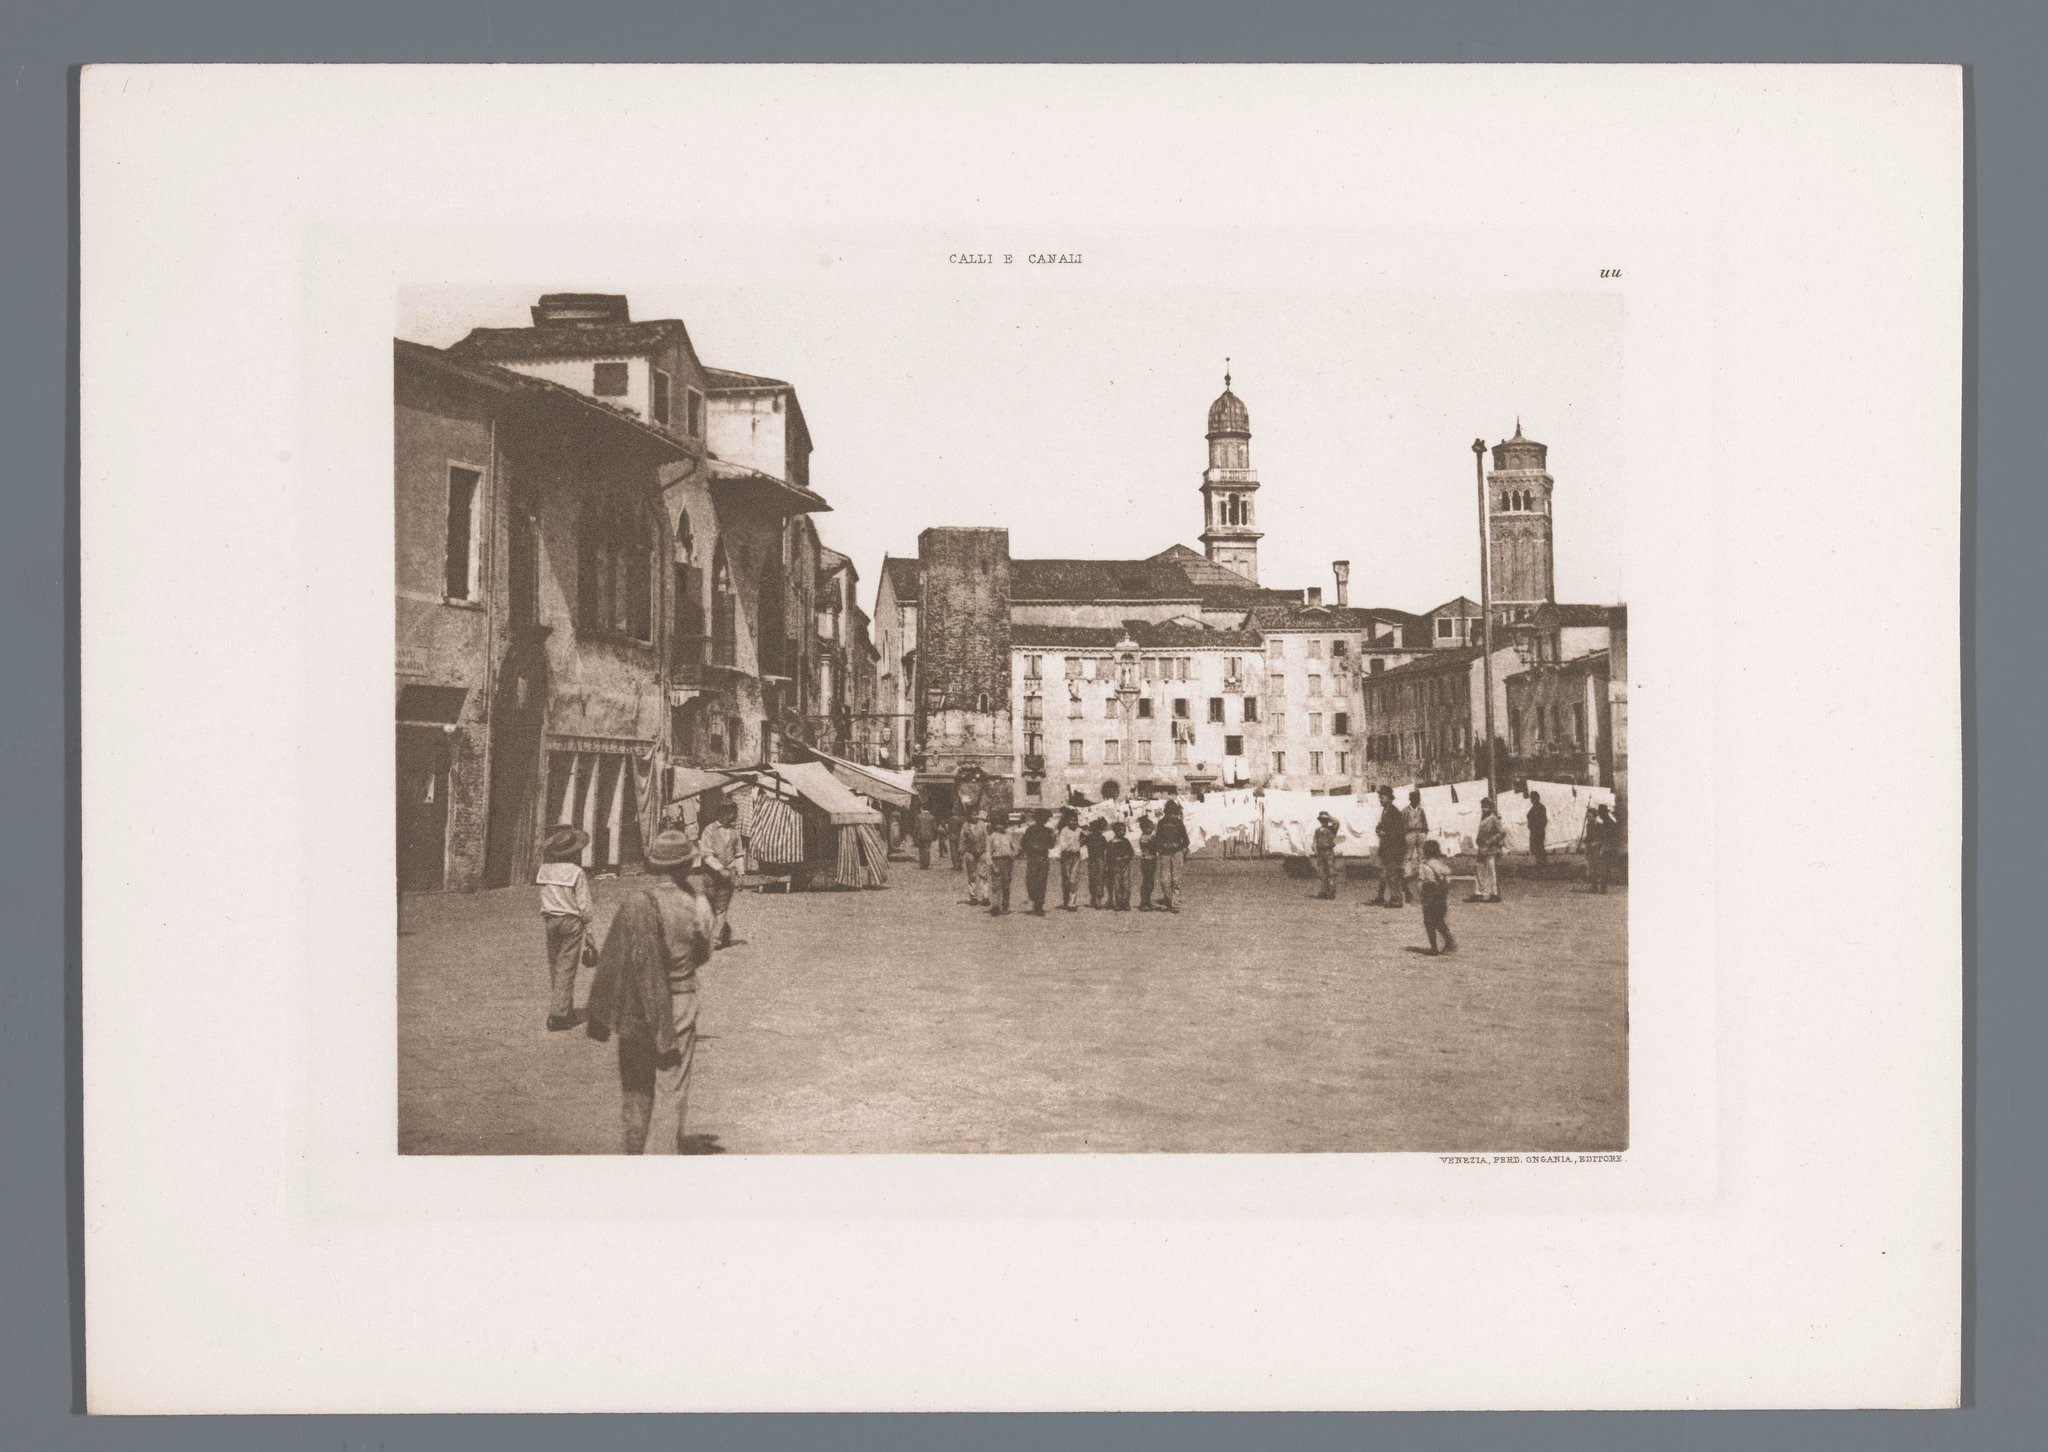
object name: photomechanical print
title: Gezicht op Campo Santa Margherita in Venetië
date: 1888-1898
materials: paper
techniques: photoaquatint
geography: venice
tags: square, place, circus, etc. (+ city(-scape) with figures, staffage), venice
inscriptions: inscription: ‘uu’